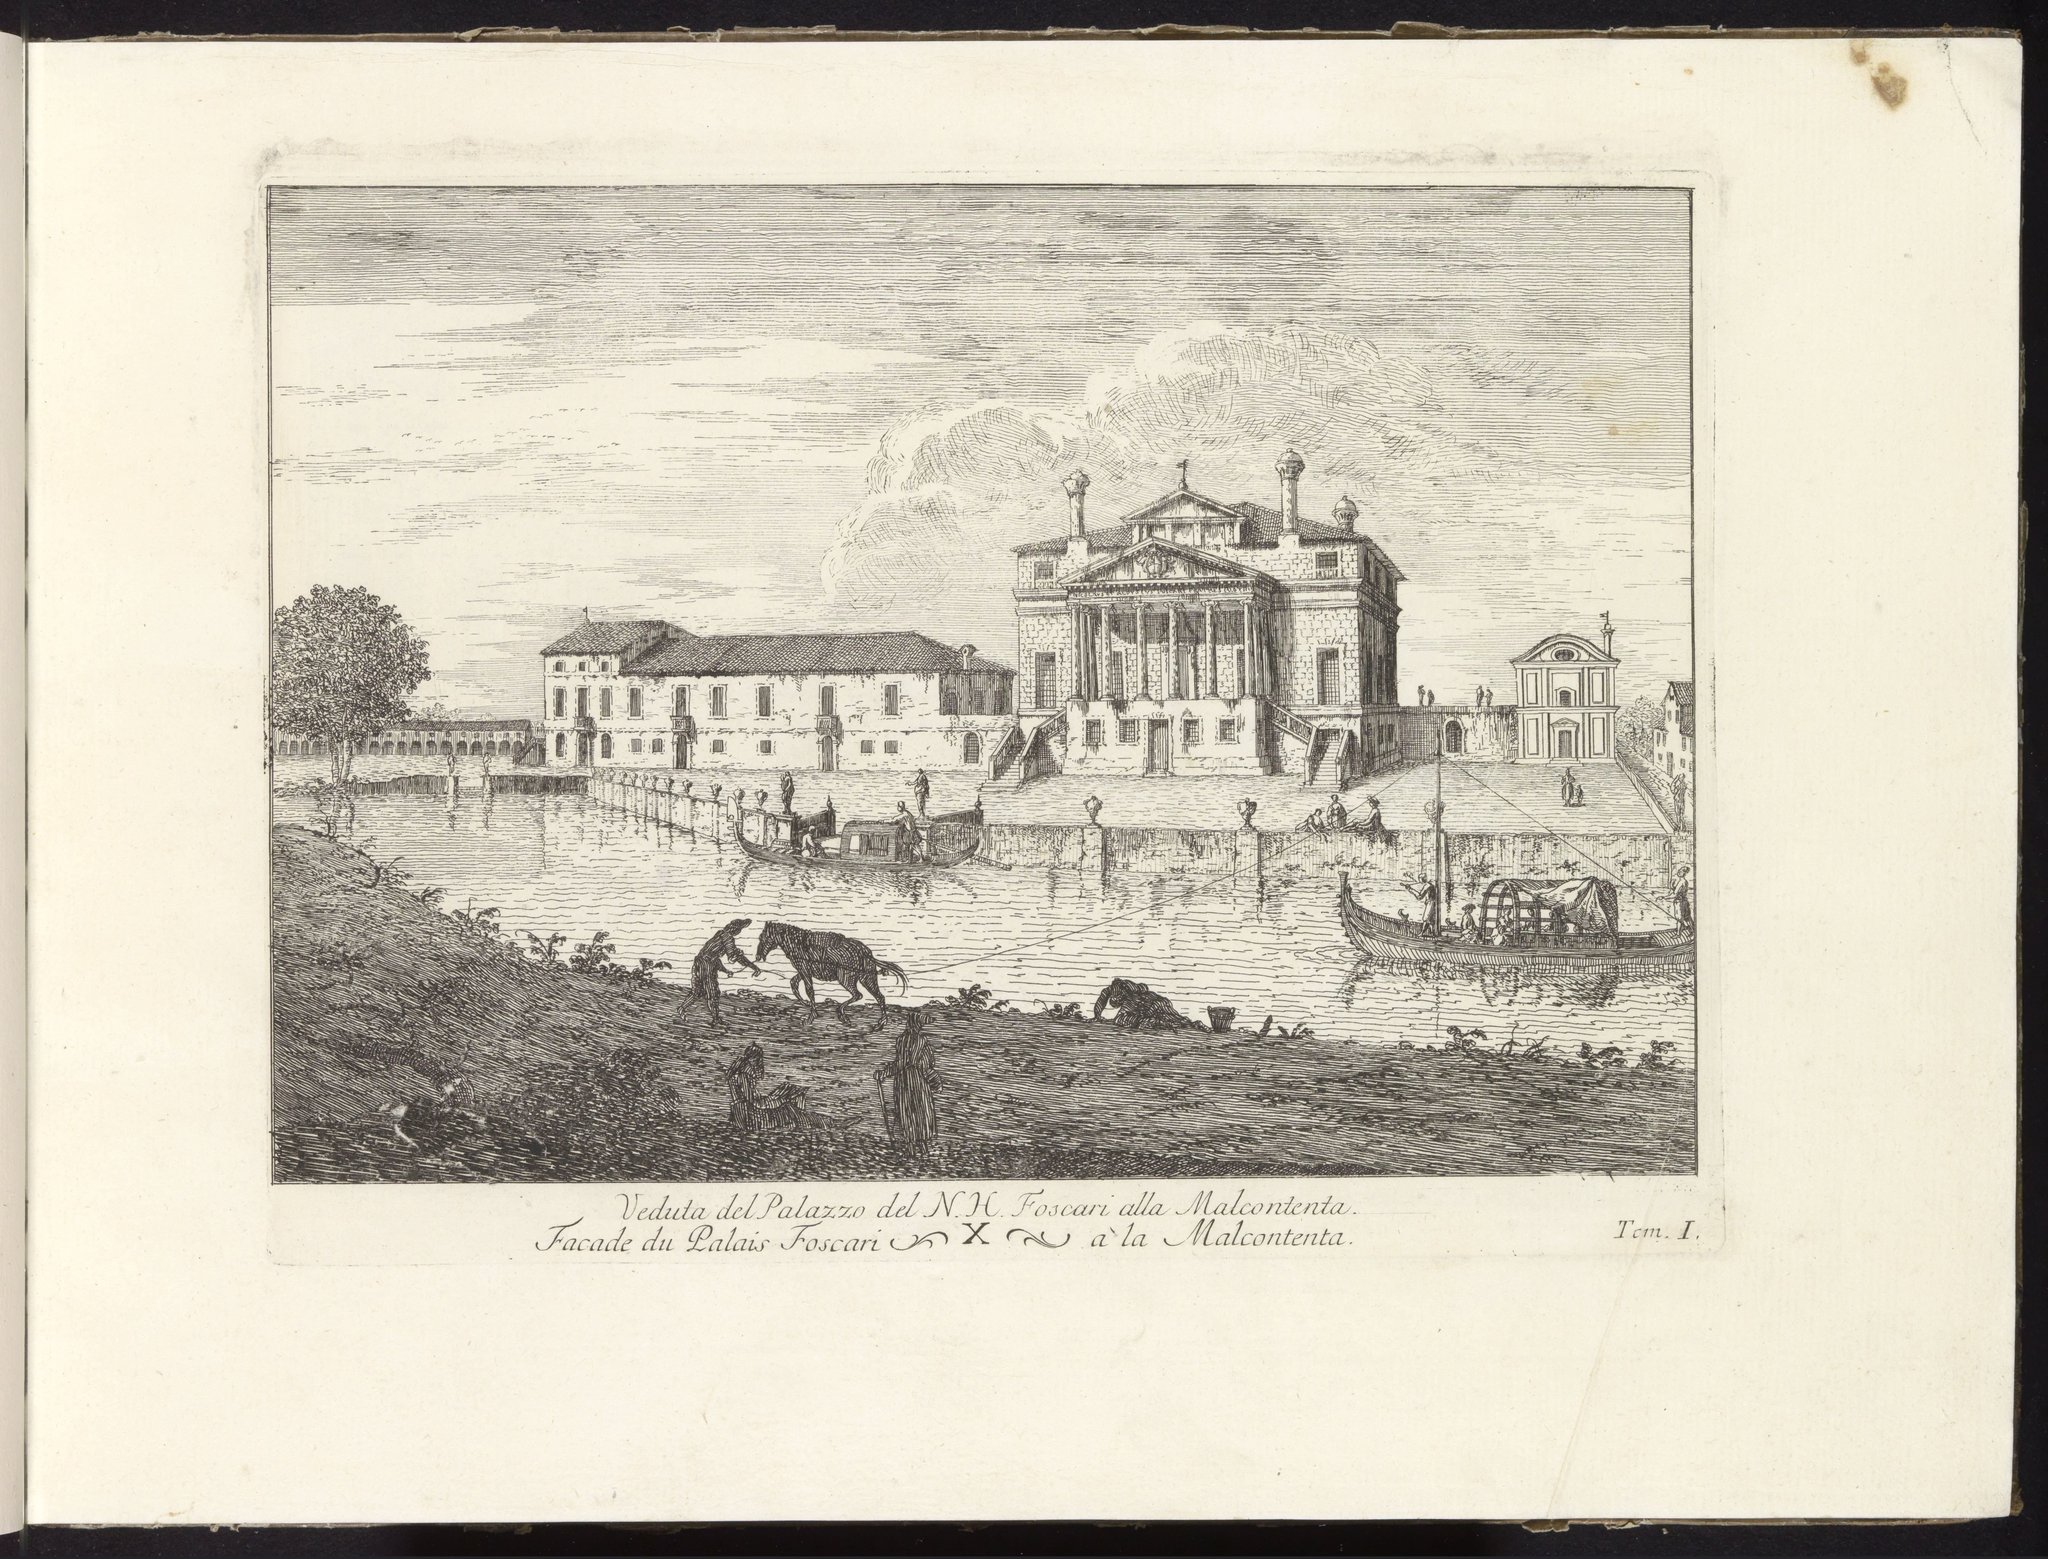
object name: print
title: Palazzo del N. H. Foscari aan de Brenta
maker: giovanni francesco costa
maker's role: draughtsman, painter, print maker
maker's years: -1773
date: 1750-1760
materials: paper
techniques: etching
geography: italy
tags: river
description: Gezicht op Palazzo del N. H. Foscari aan de rivier de Brenta. Genummerd midden onder: X en rechtsonder: Tom: I. Deze prent maakt deel uit van een album.